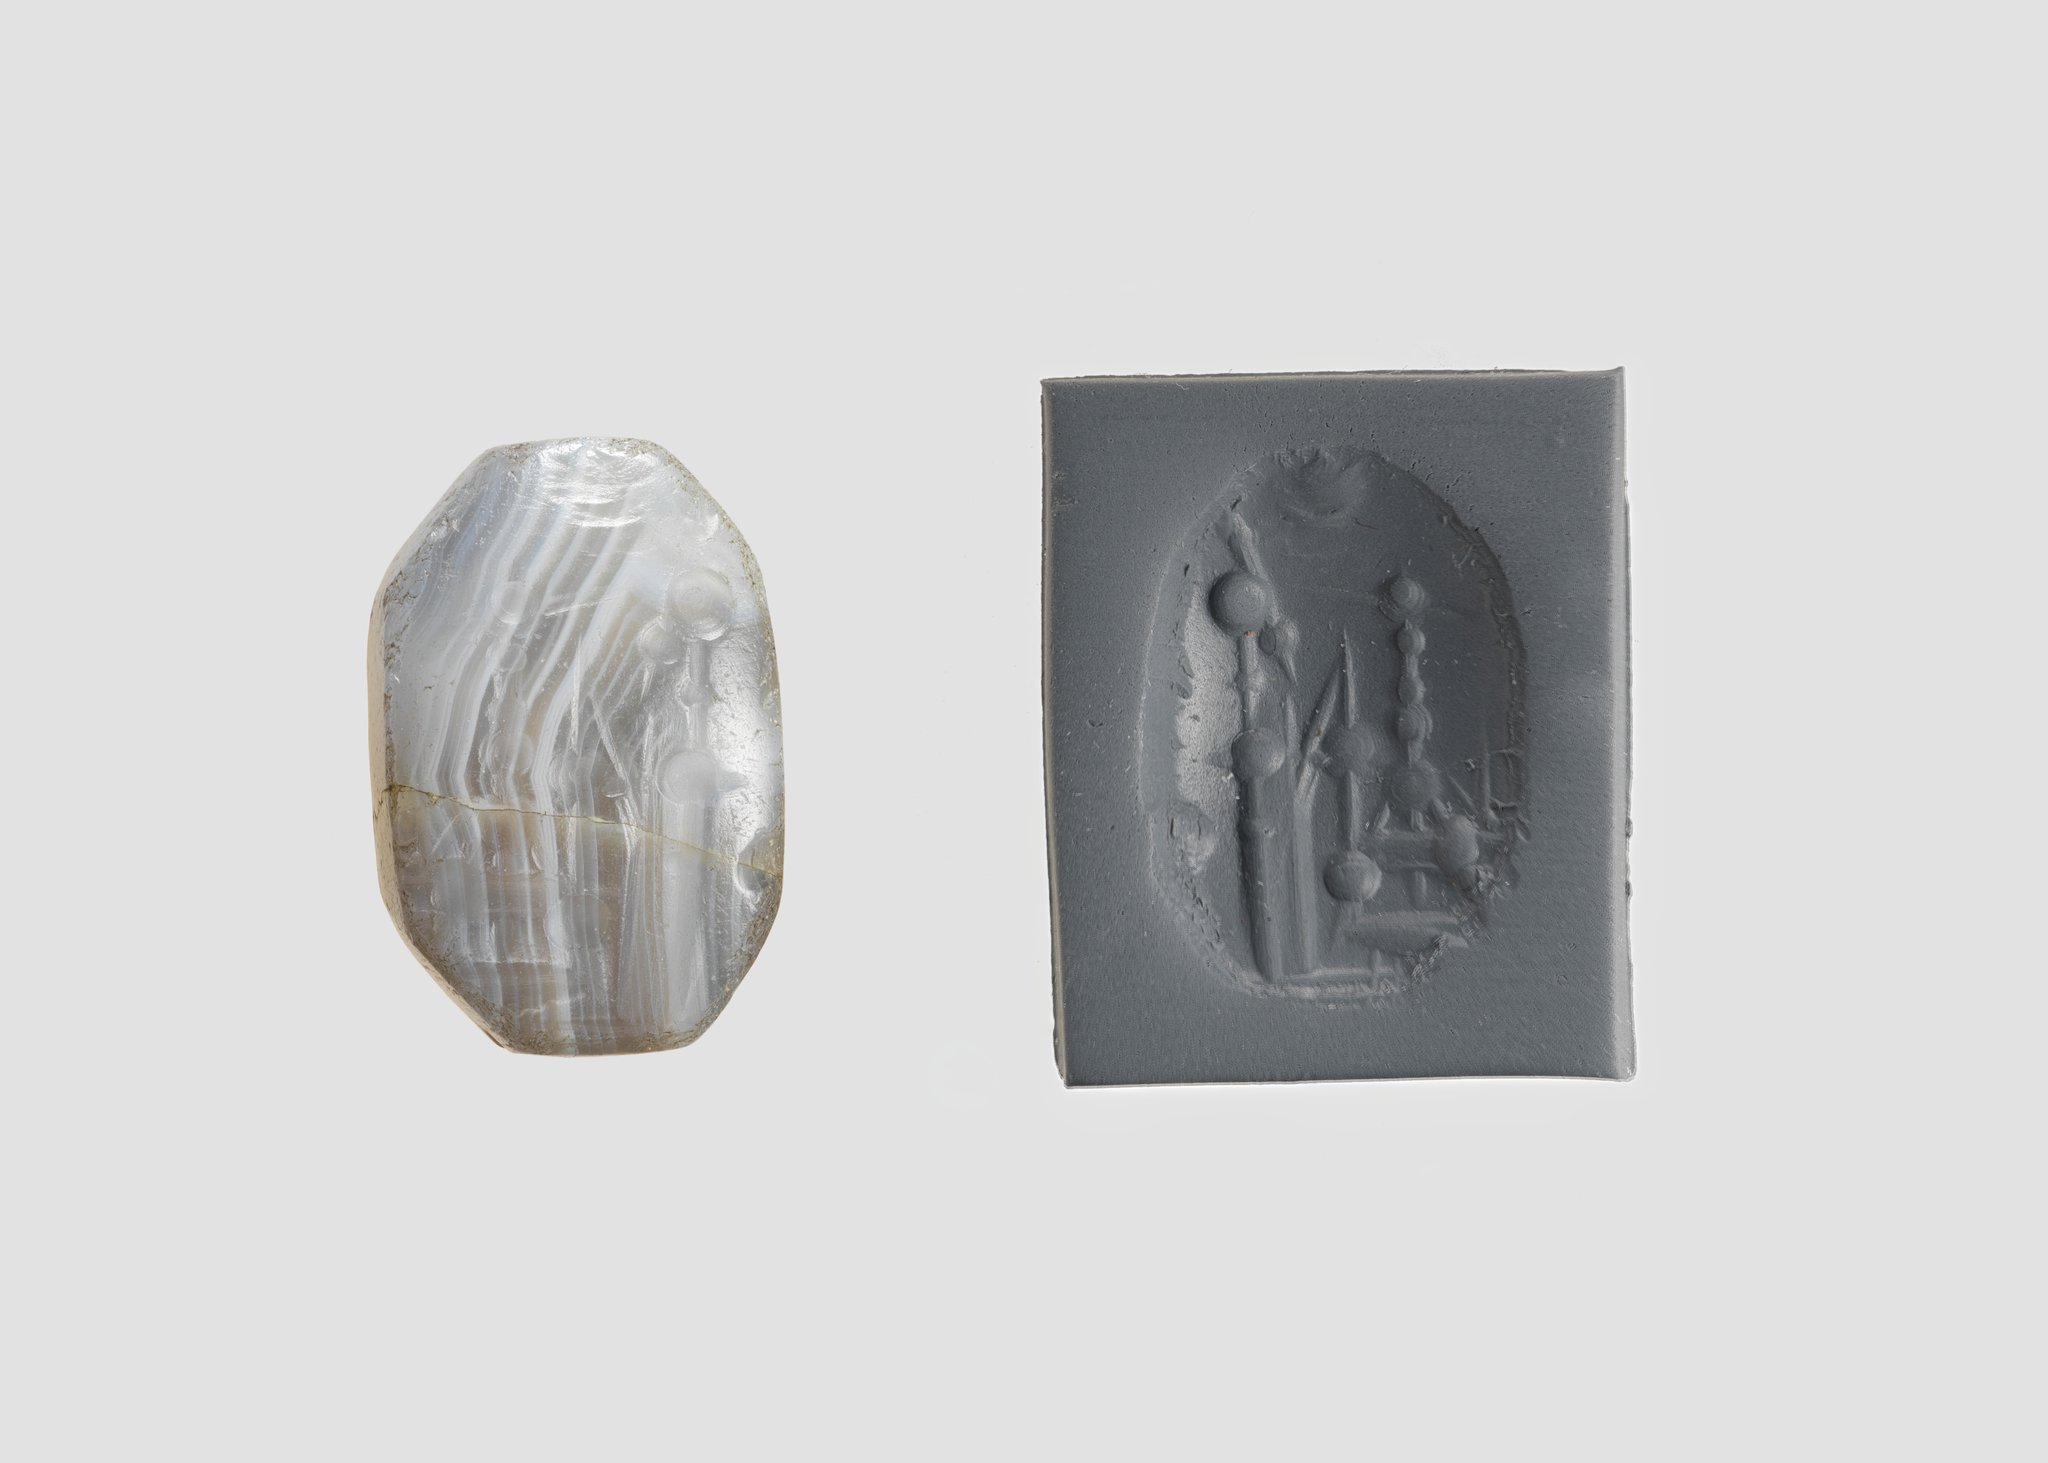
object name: stamp seal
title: Stamp seal (octagonal pyramid) with cultic scene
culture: assyro-babylonian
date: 700-501 BCE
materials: stone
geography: mesopotamia